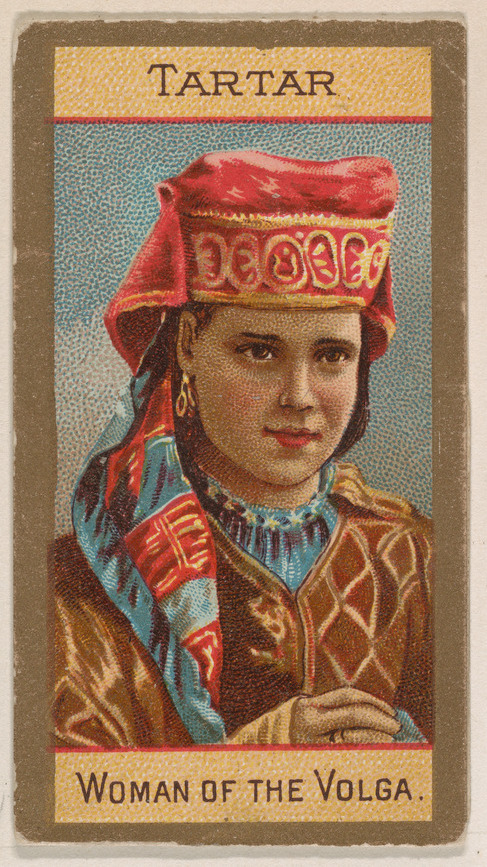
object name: print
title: Tartar, Woman of the Volga, from Types of Nationalities (N240) issued by Kinney Bros.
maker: kinney brothers tobacco company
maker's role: publisher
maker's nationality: american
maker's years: 1869-2011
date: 1890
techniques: color lithograph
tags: women